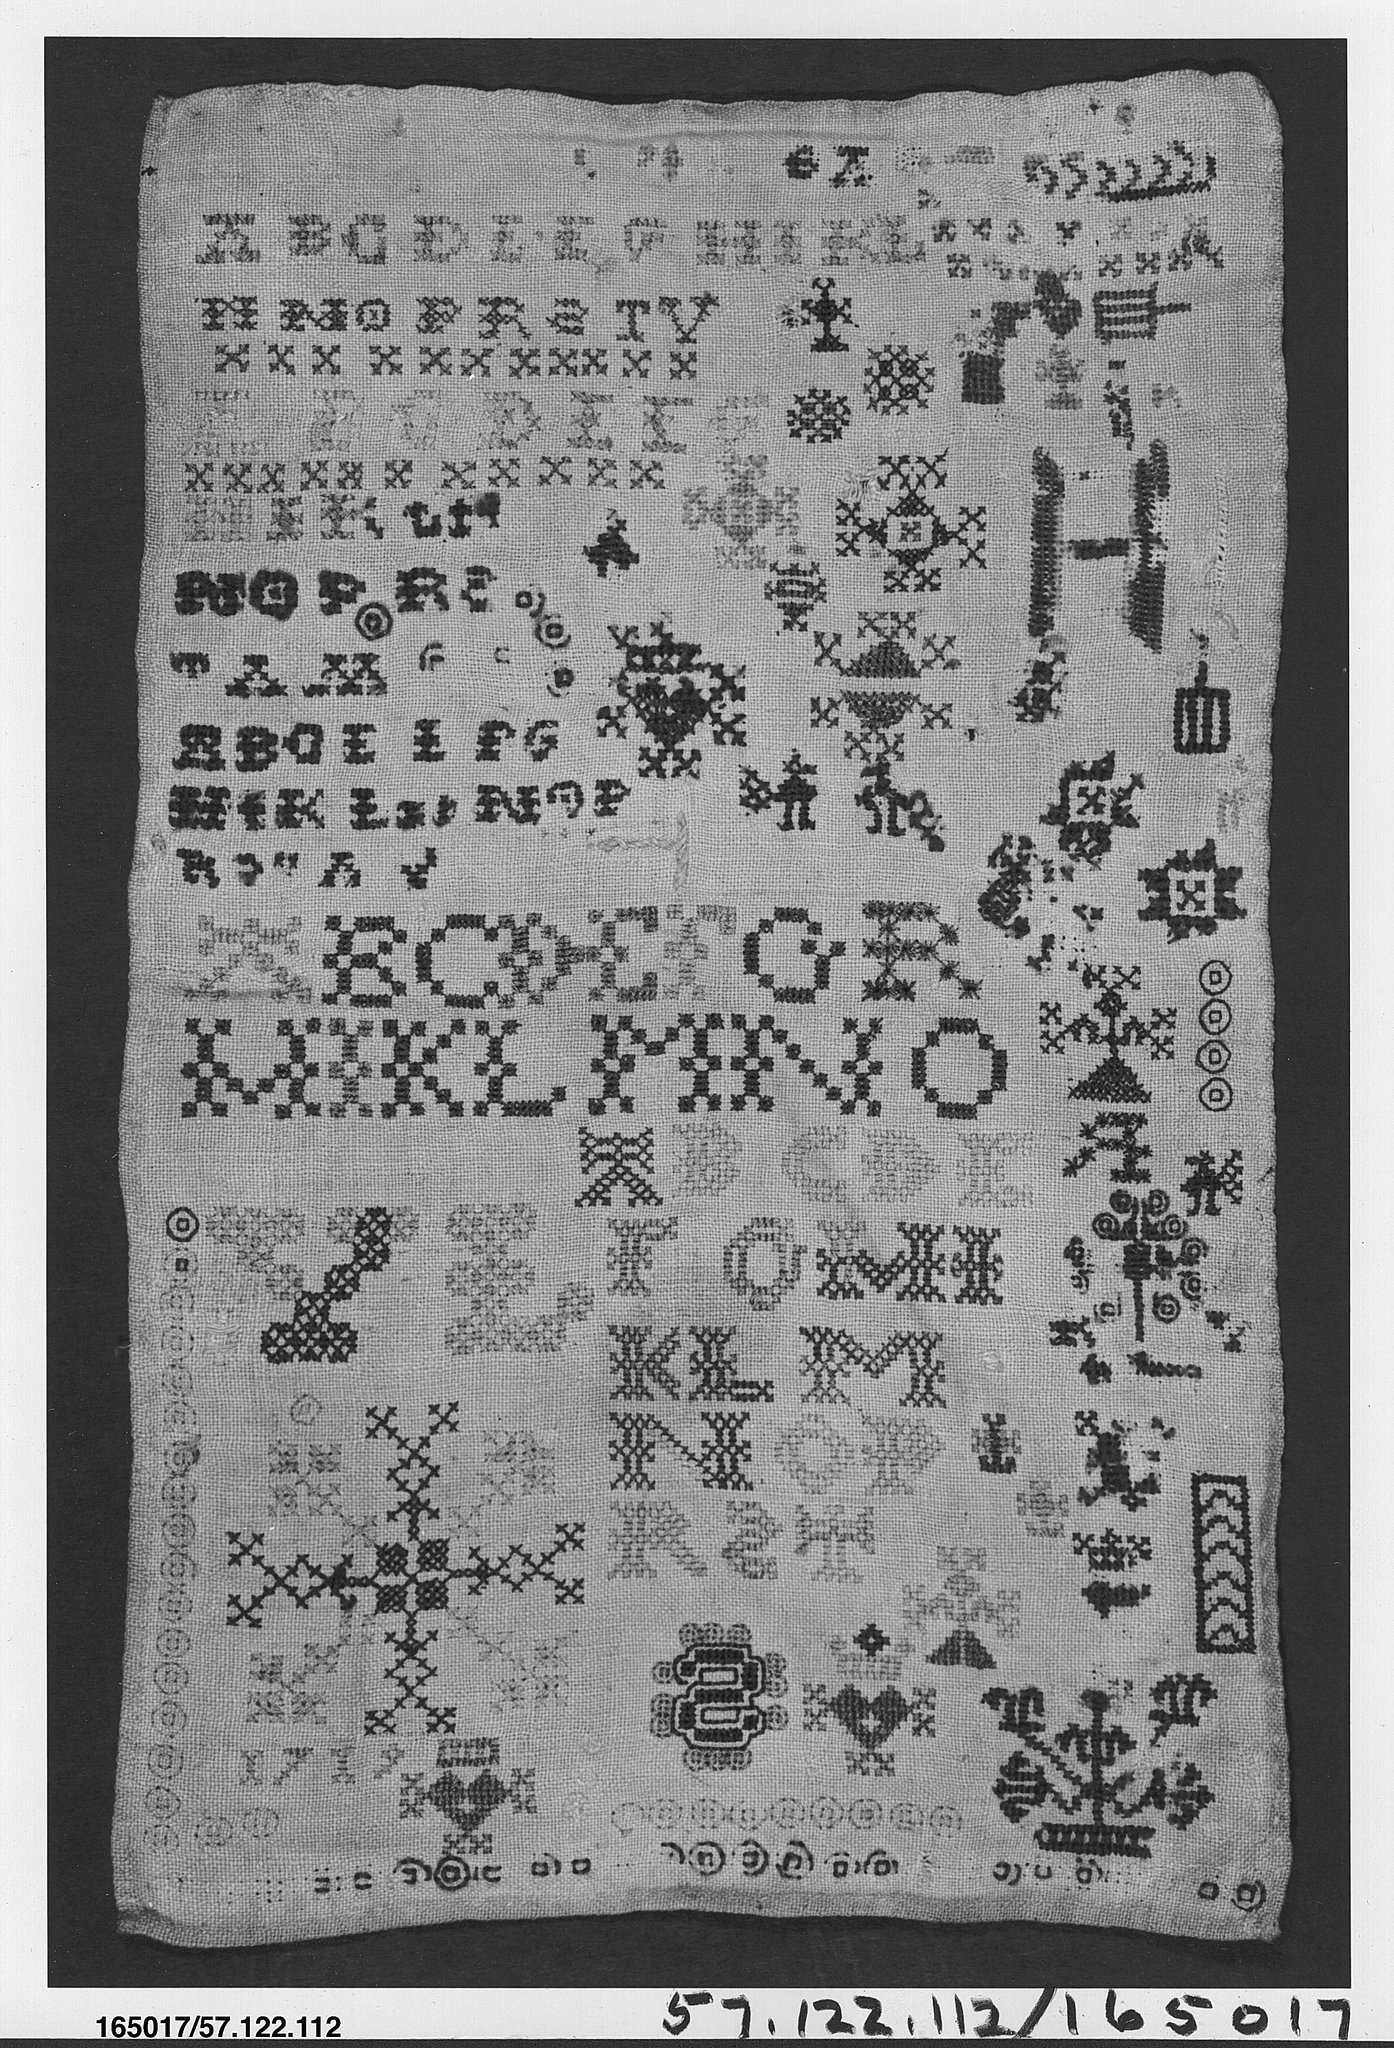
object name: sampler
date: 1719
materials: linen, silk, wool